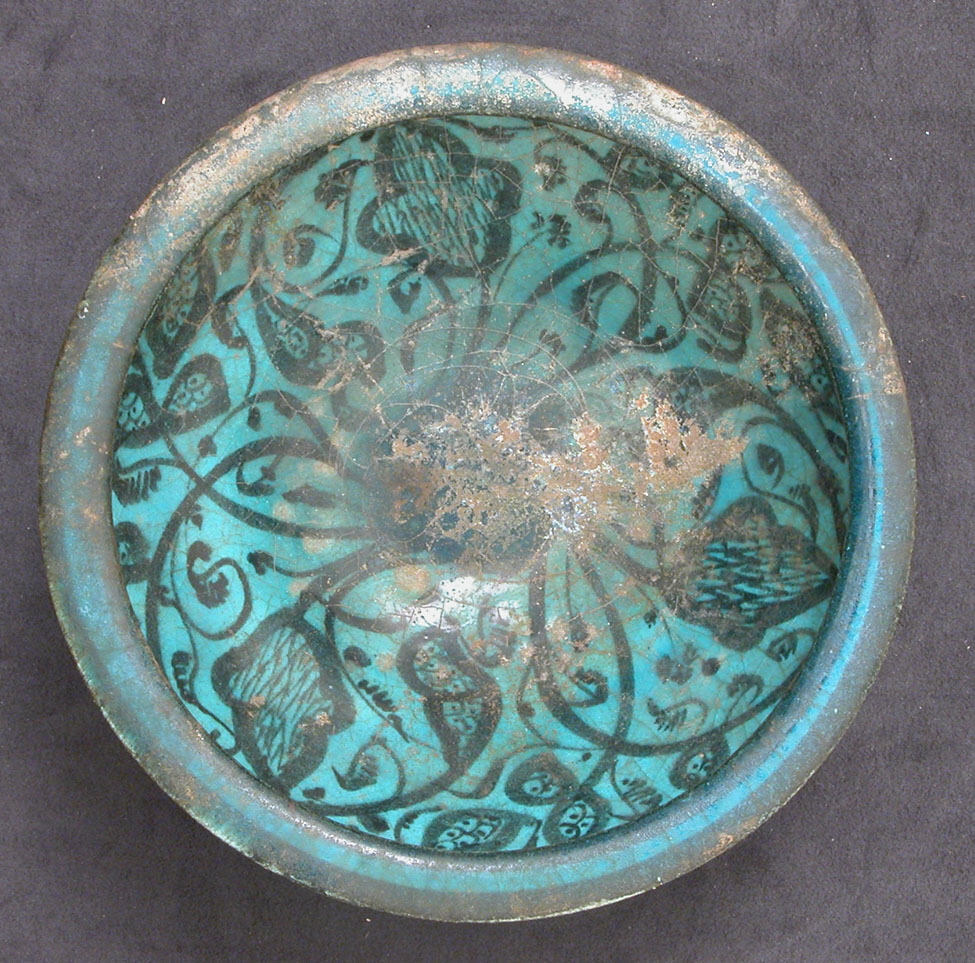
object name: bowl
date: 1201-1300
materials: stonepaste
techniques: glazing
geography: iran